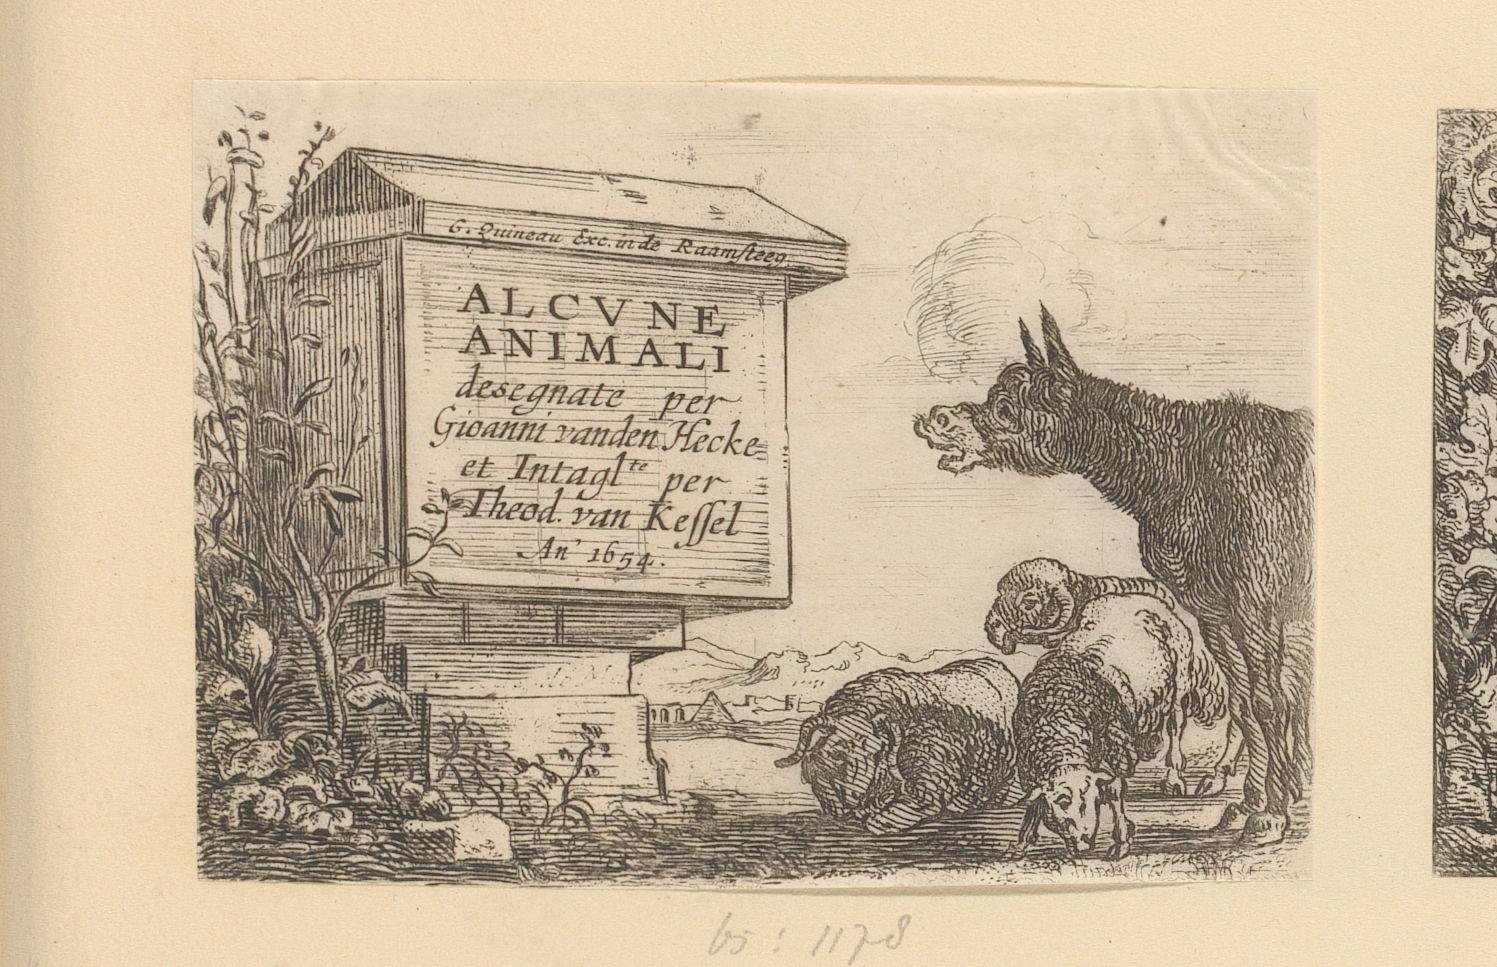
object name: print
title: Ezel, schaap en rammen bij een steen met opschrift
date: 1654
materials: paper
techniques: etching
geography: amsterdam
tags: ass, donkey, sheep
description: Titelprent voor een serie van tien prenten. Prent maakt mogelijk deel uit van een serie van 200 prenten. Deze serie is onder de titel 'A Collection of two hundred original etchings' voor het eerst uitgegeven door J.M. Greery in 1816.